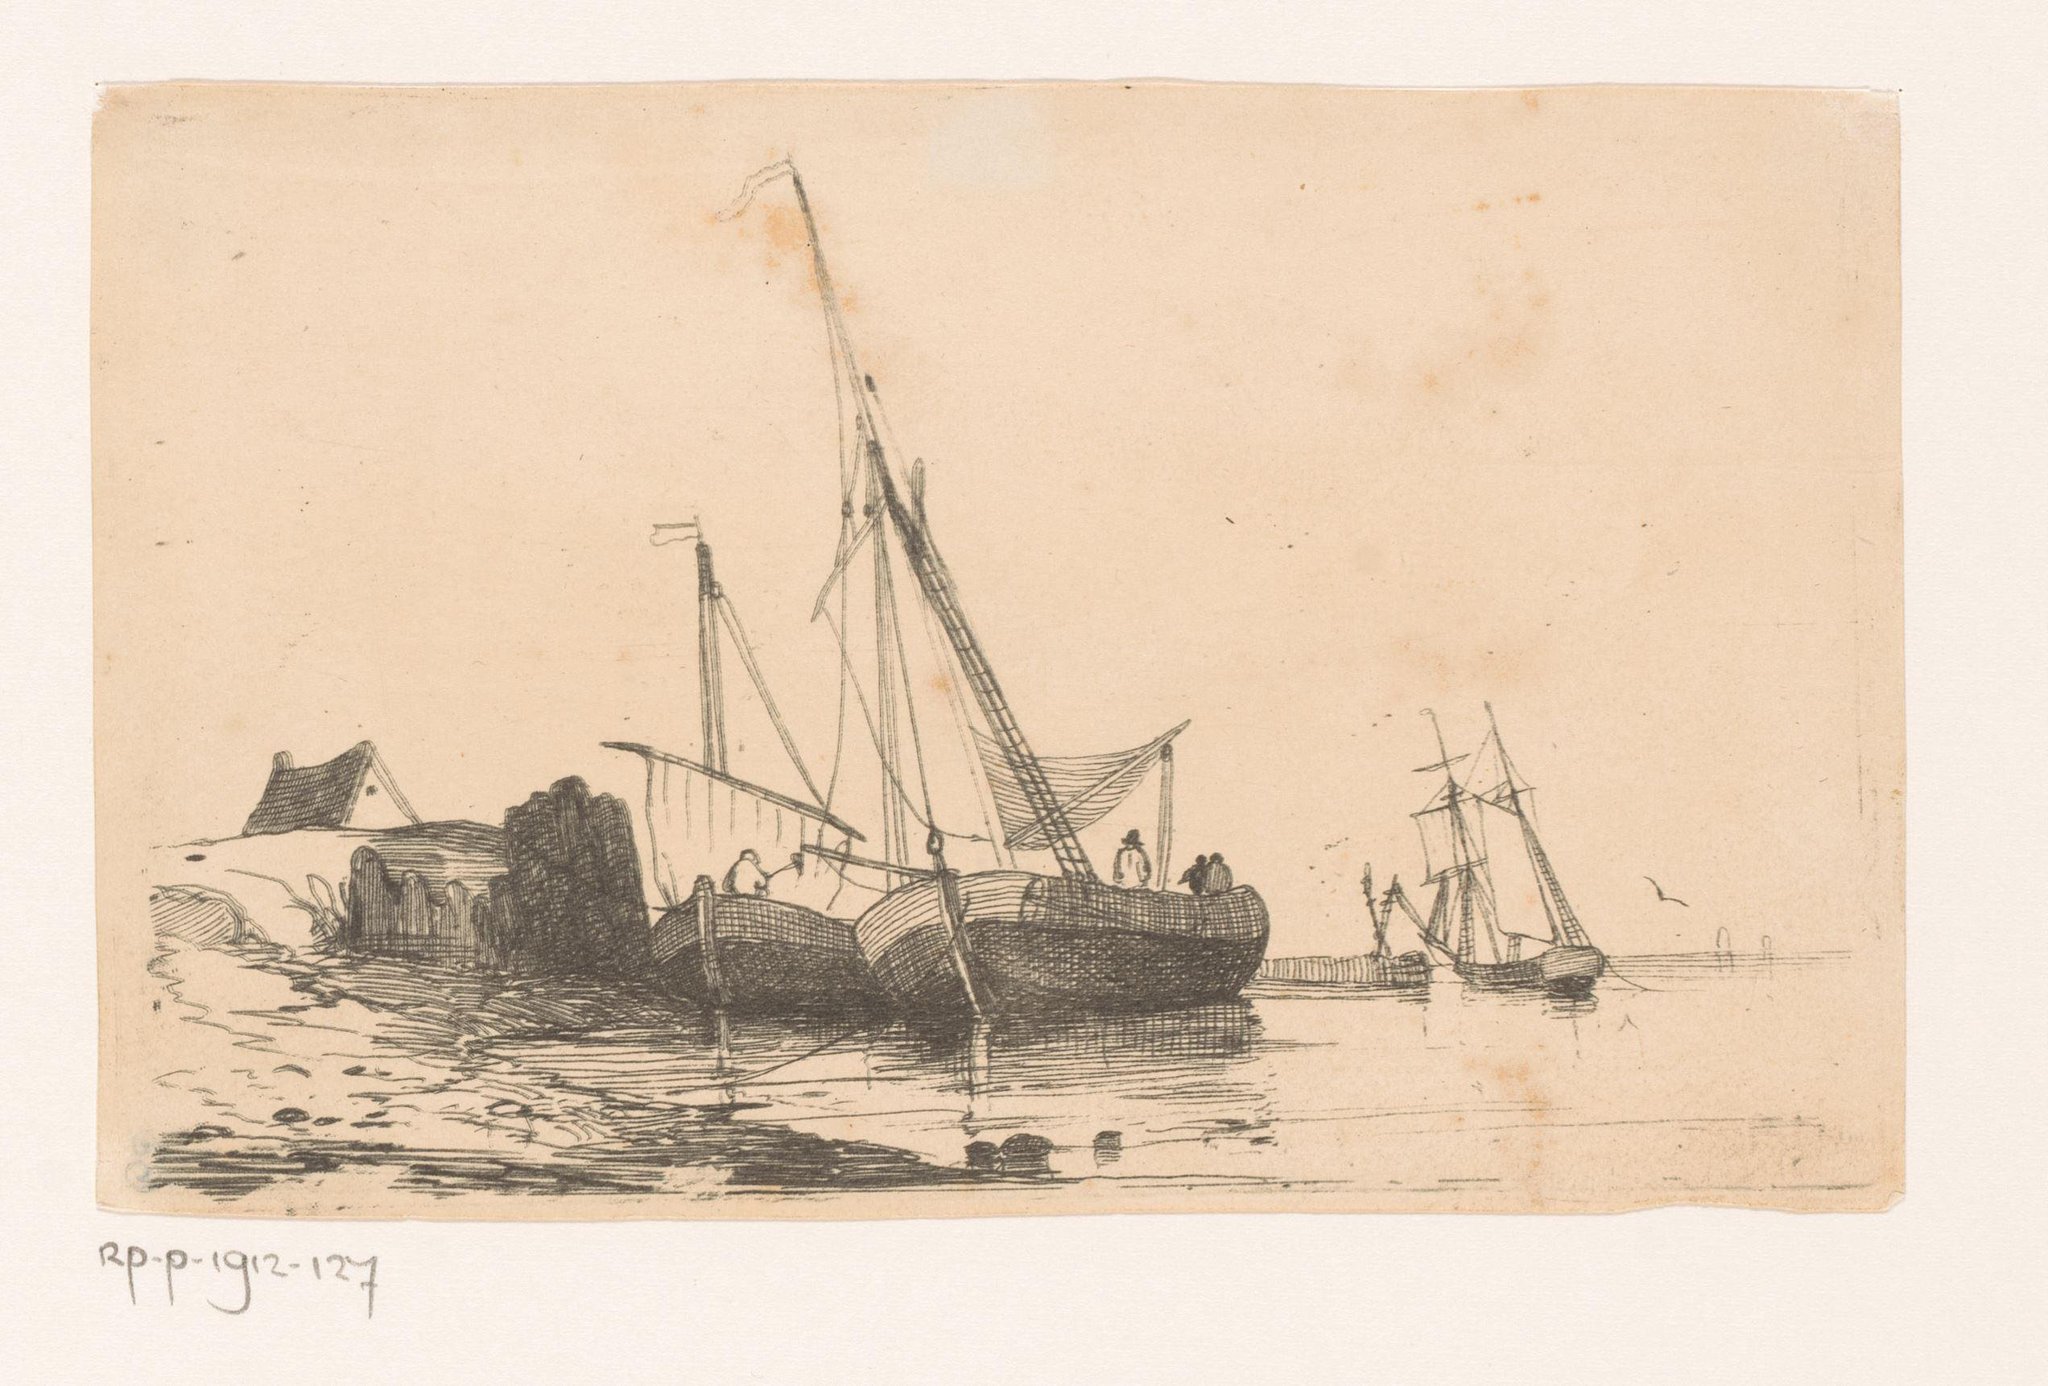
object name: print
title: Twee zeilschepen aan de kust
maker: egidius linnig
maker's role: draughtsman, print maker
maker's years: 1821-1860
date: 1831-1860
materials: paper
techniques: printmaking, etching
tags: sailing-ship, sailing-boat, ships, boats on land, beached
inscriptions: collector's mark: Lugt 2228, collector's mark: Lugt 1485